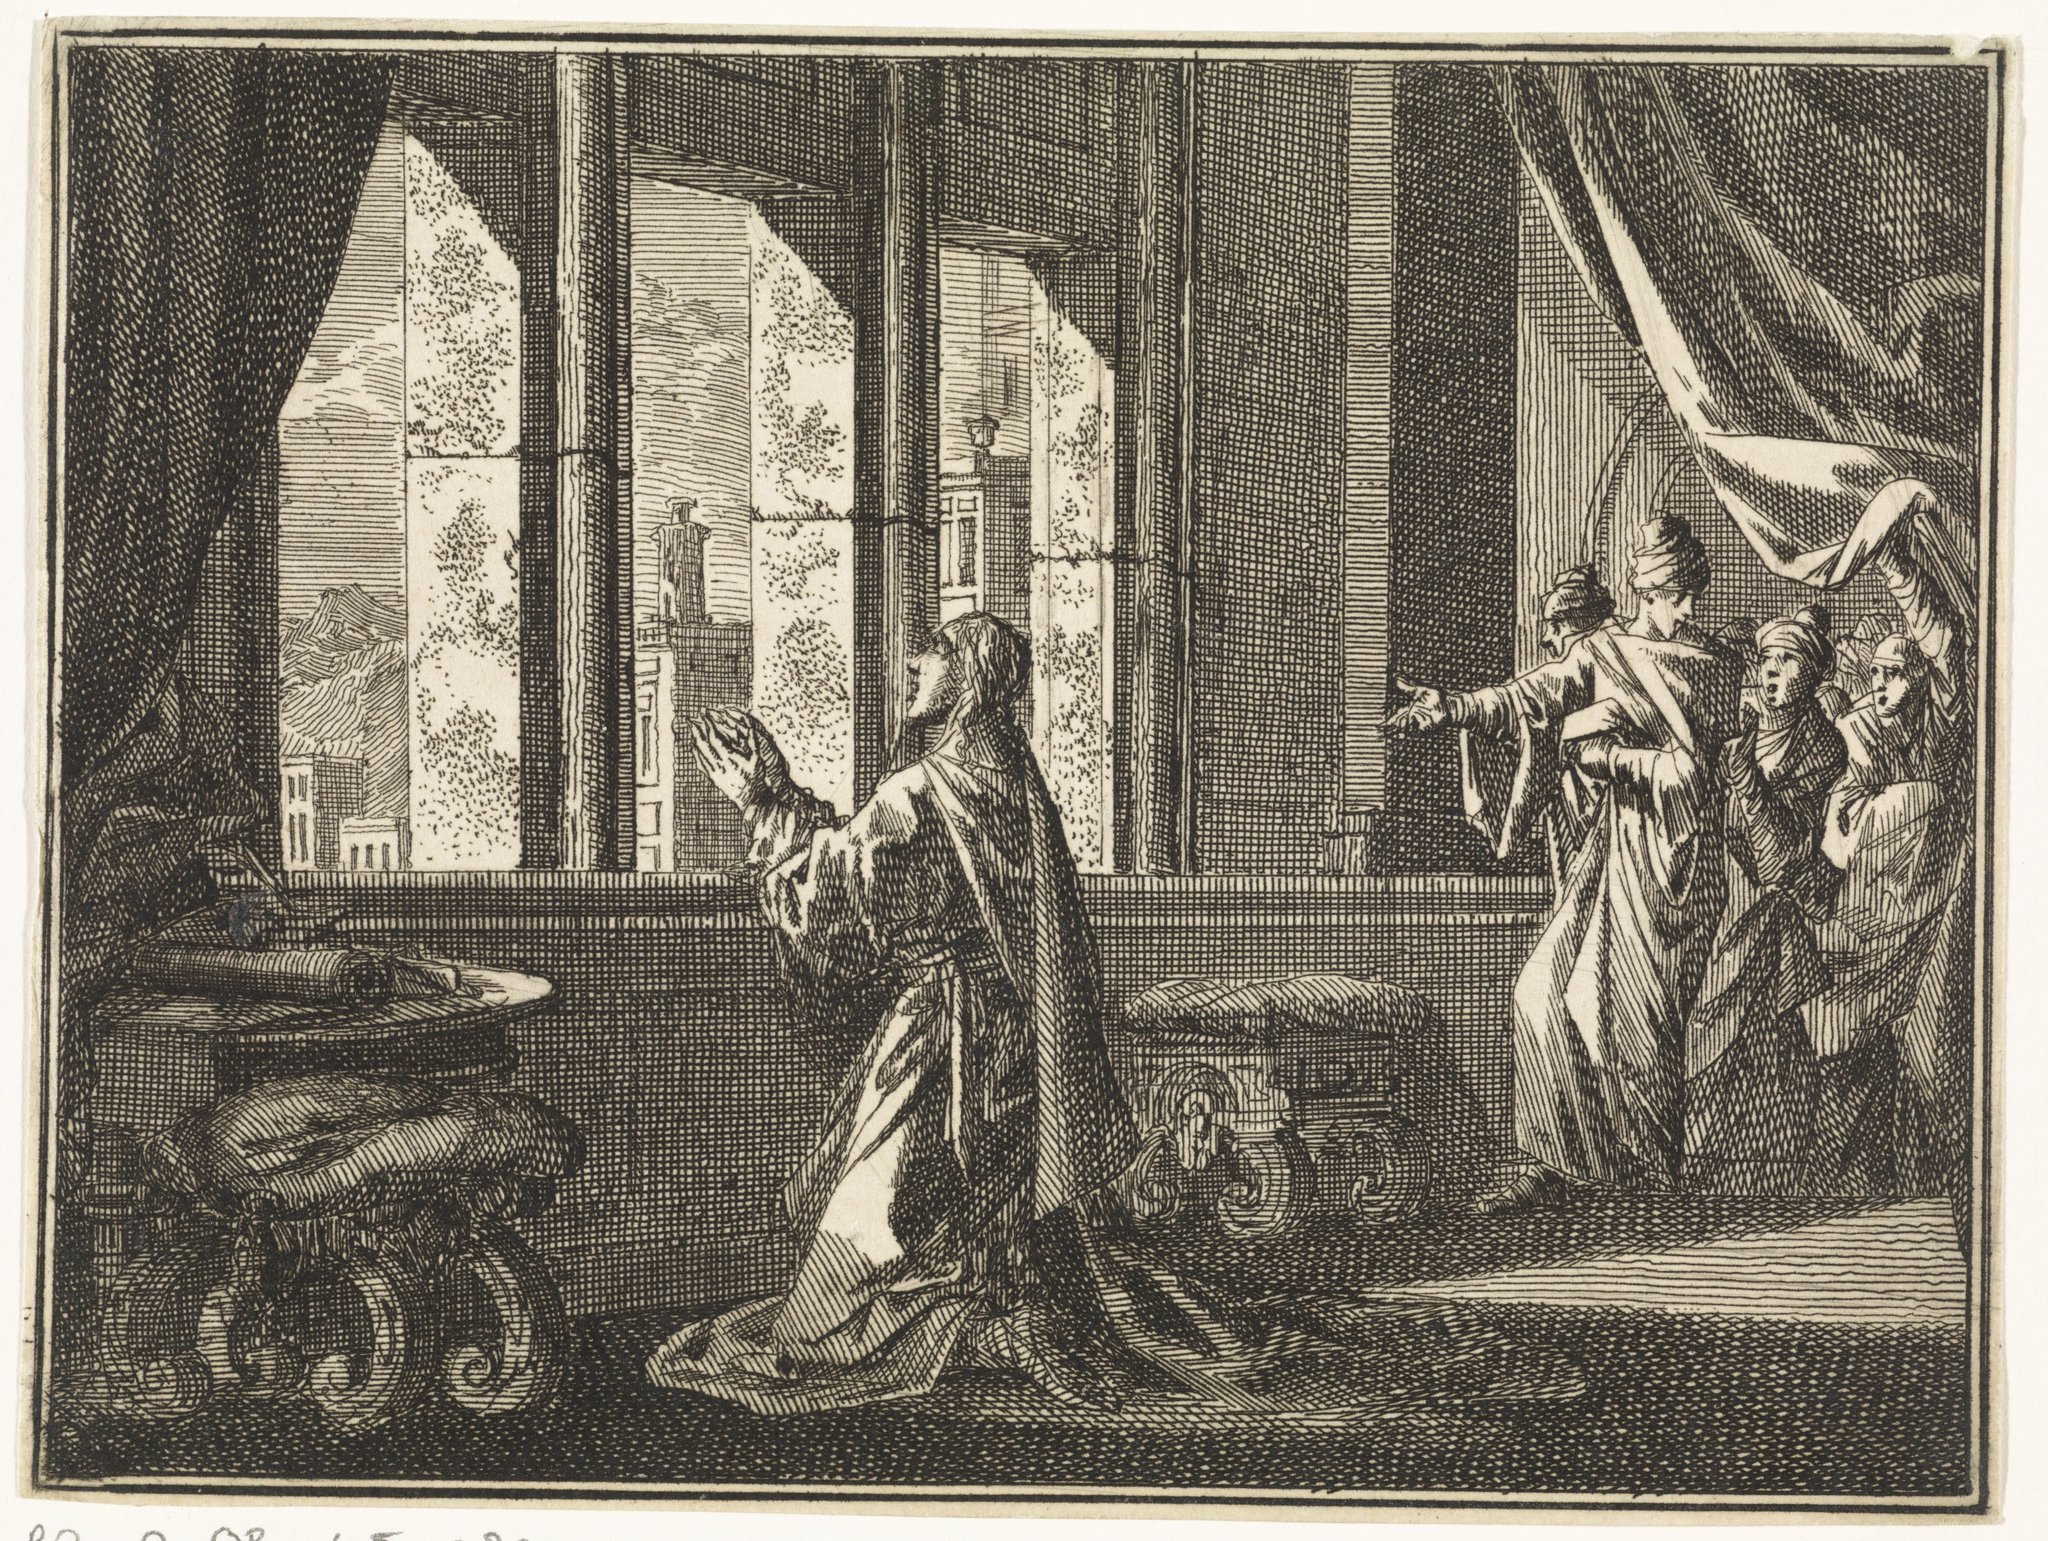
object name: print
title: Daniël in gebed geknield voor een venster wordt bespied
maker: jan luyken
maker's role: draughtsman, print maker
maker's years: 1649-1712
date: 1712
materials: paper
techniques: etching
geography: amsterdam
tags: daniel, while praying on his knees before an open window, is discovered by the conspirators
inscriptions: number: ‘166’, collector's mark: Lugt 2228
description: Illustratie uit: Luyken, Jan. De schriftuurlyke geschiedenissen en gelykenissen van het Oude en Nieuwe Verbond, 2 delen. Amsterdam: Wed. Pieter Arentsz II en Cornelis van der Sys, 1712, dl. I.